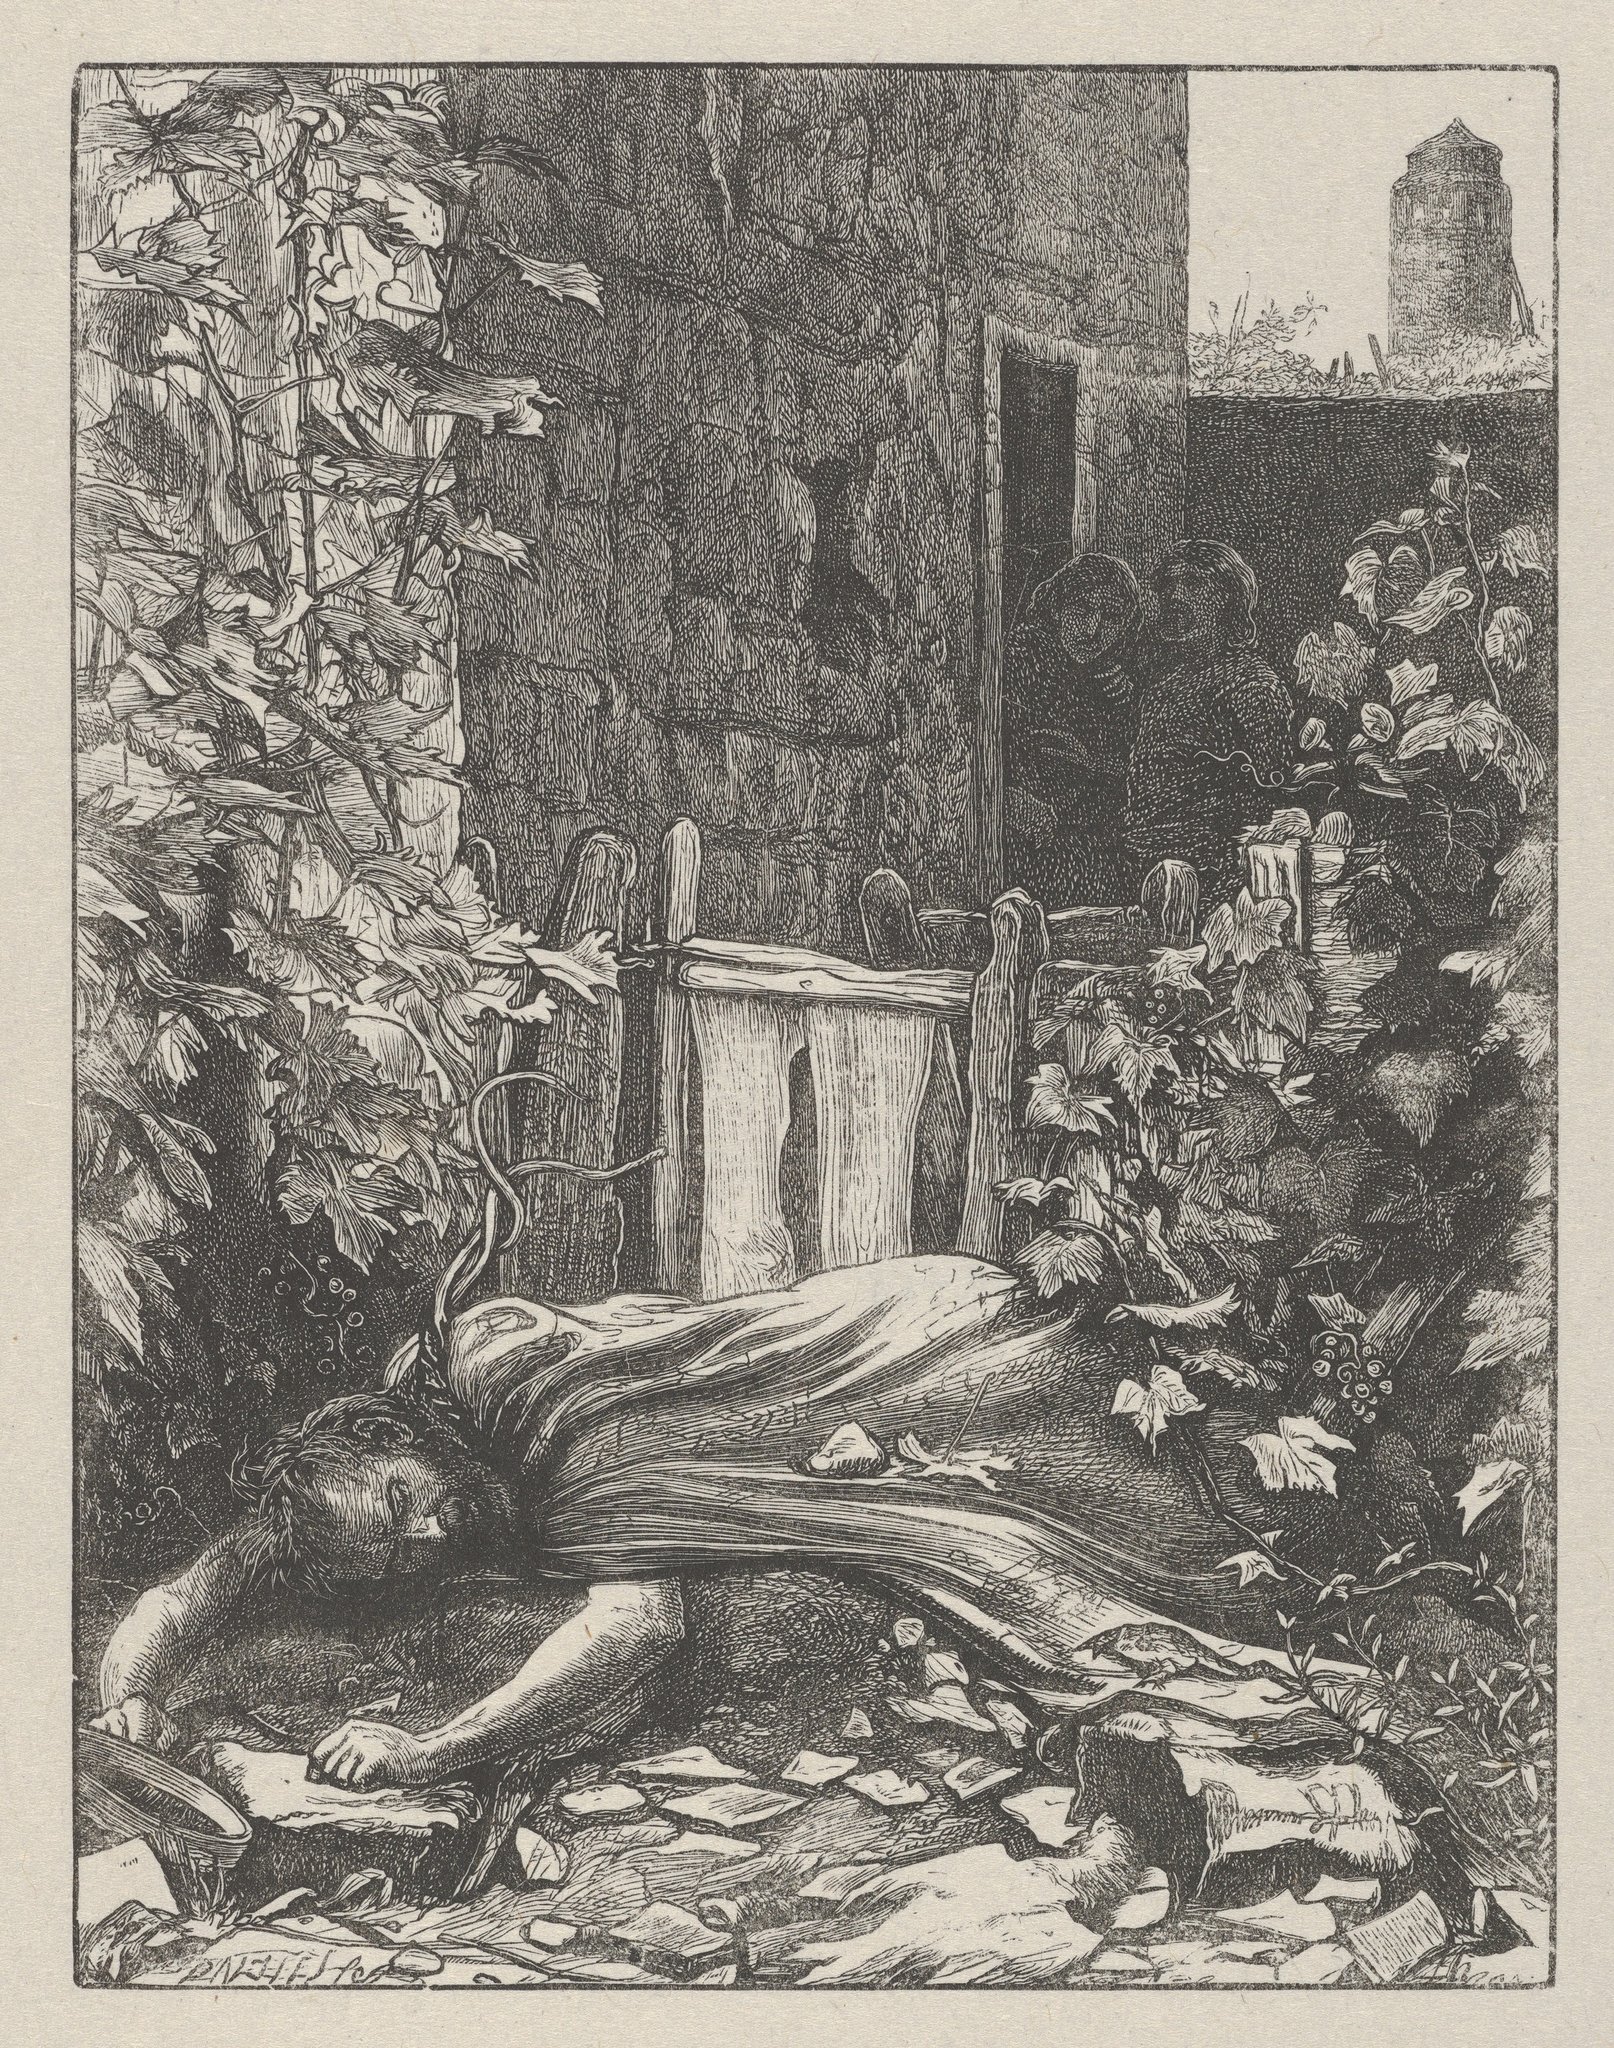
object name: print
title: The Wicked Husbandmen (The Parables of Our Lord and Saviour Jesus Christ)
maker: sir john everett millais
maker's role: artist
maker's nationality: british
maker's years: 1829-1896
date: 1864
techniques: engraving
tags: men,death